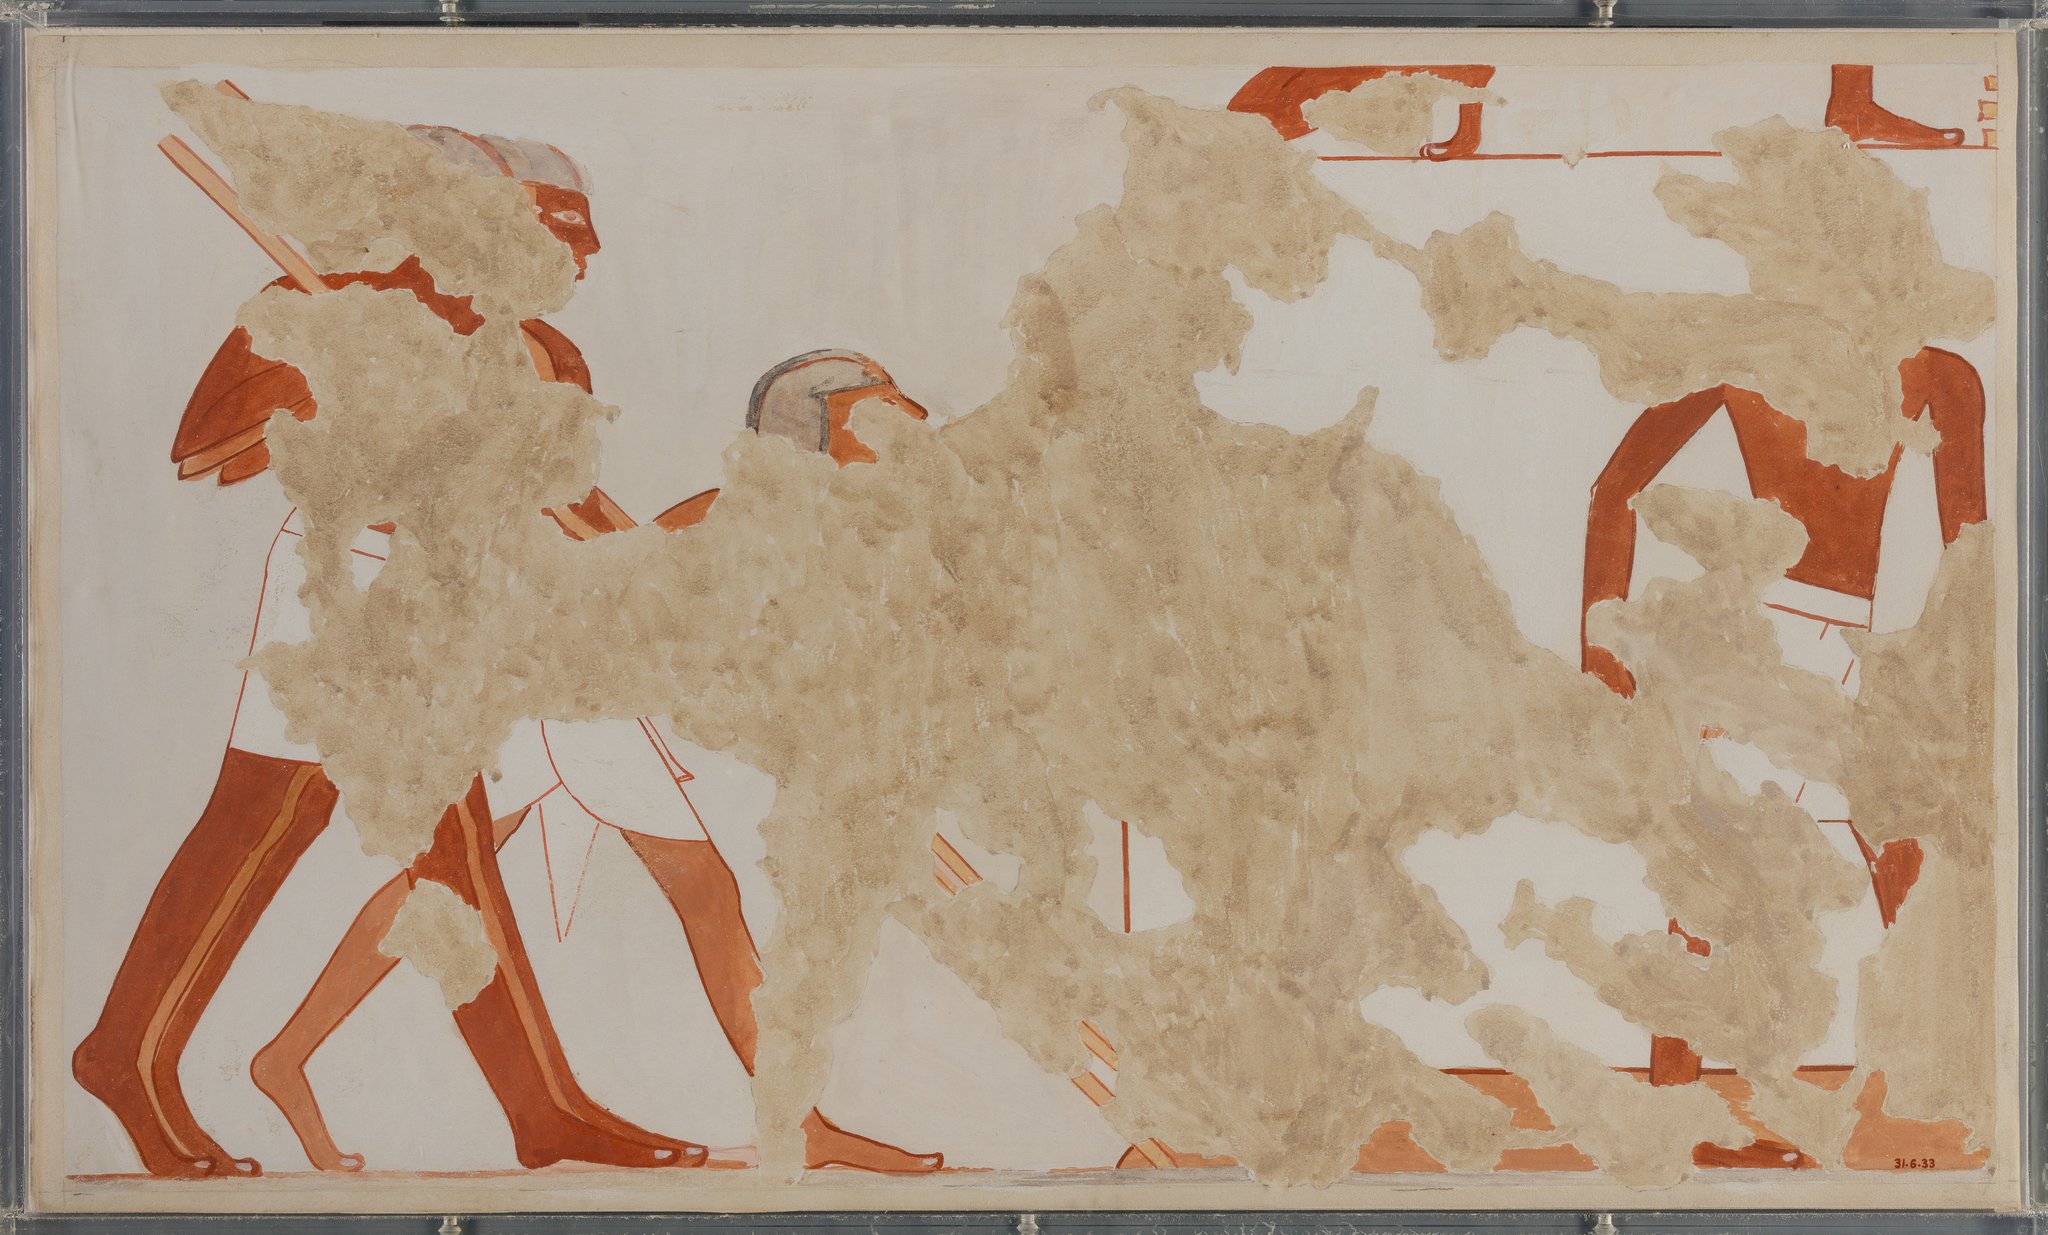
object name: facsimile, rekhmire tt 100, stone mason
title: Moving a Stone Block, Tomb of Rekhmire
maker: nina de garis davies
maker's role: artist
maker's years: 1881-1965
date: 1504-1425 BCE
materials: ink, paint, paper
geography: egypt